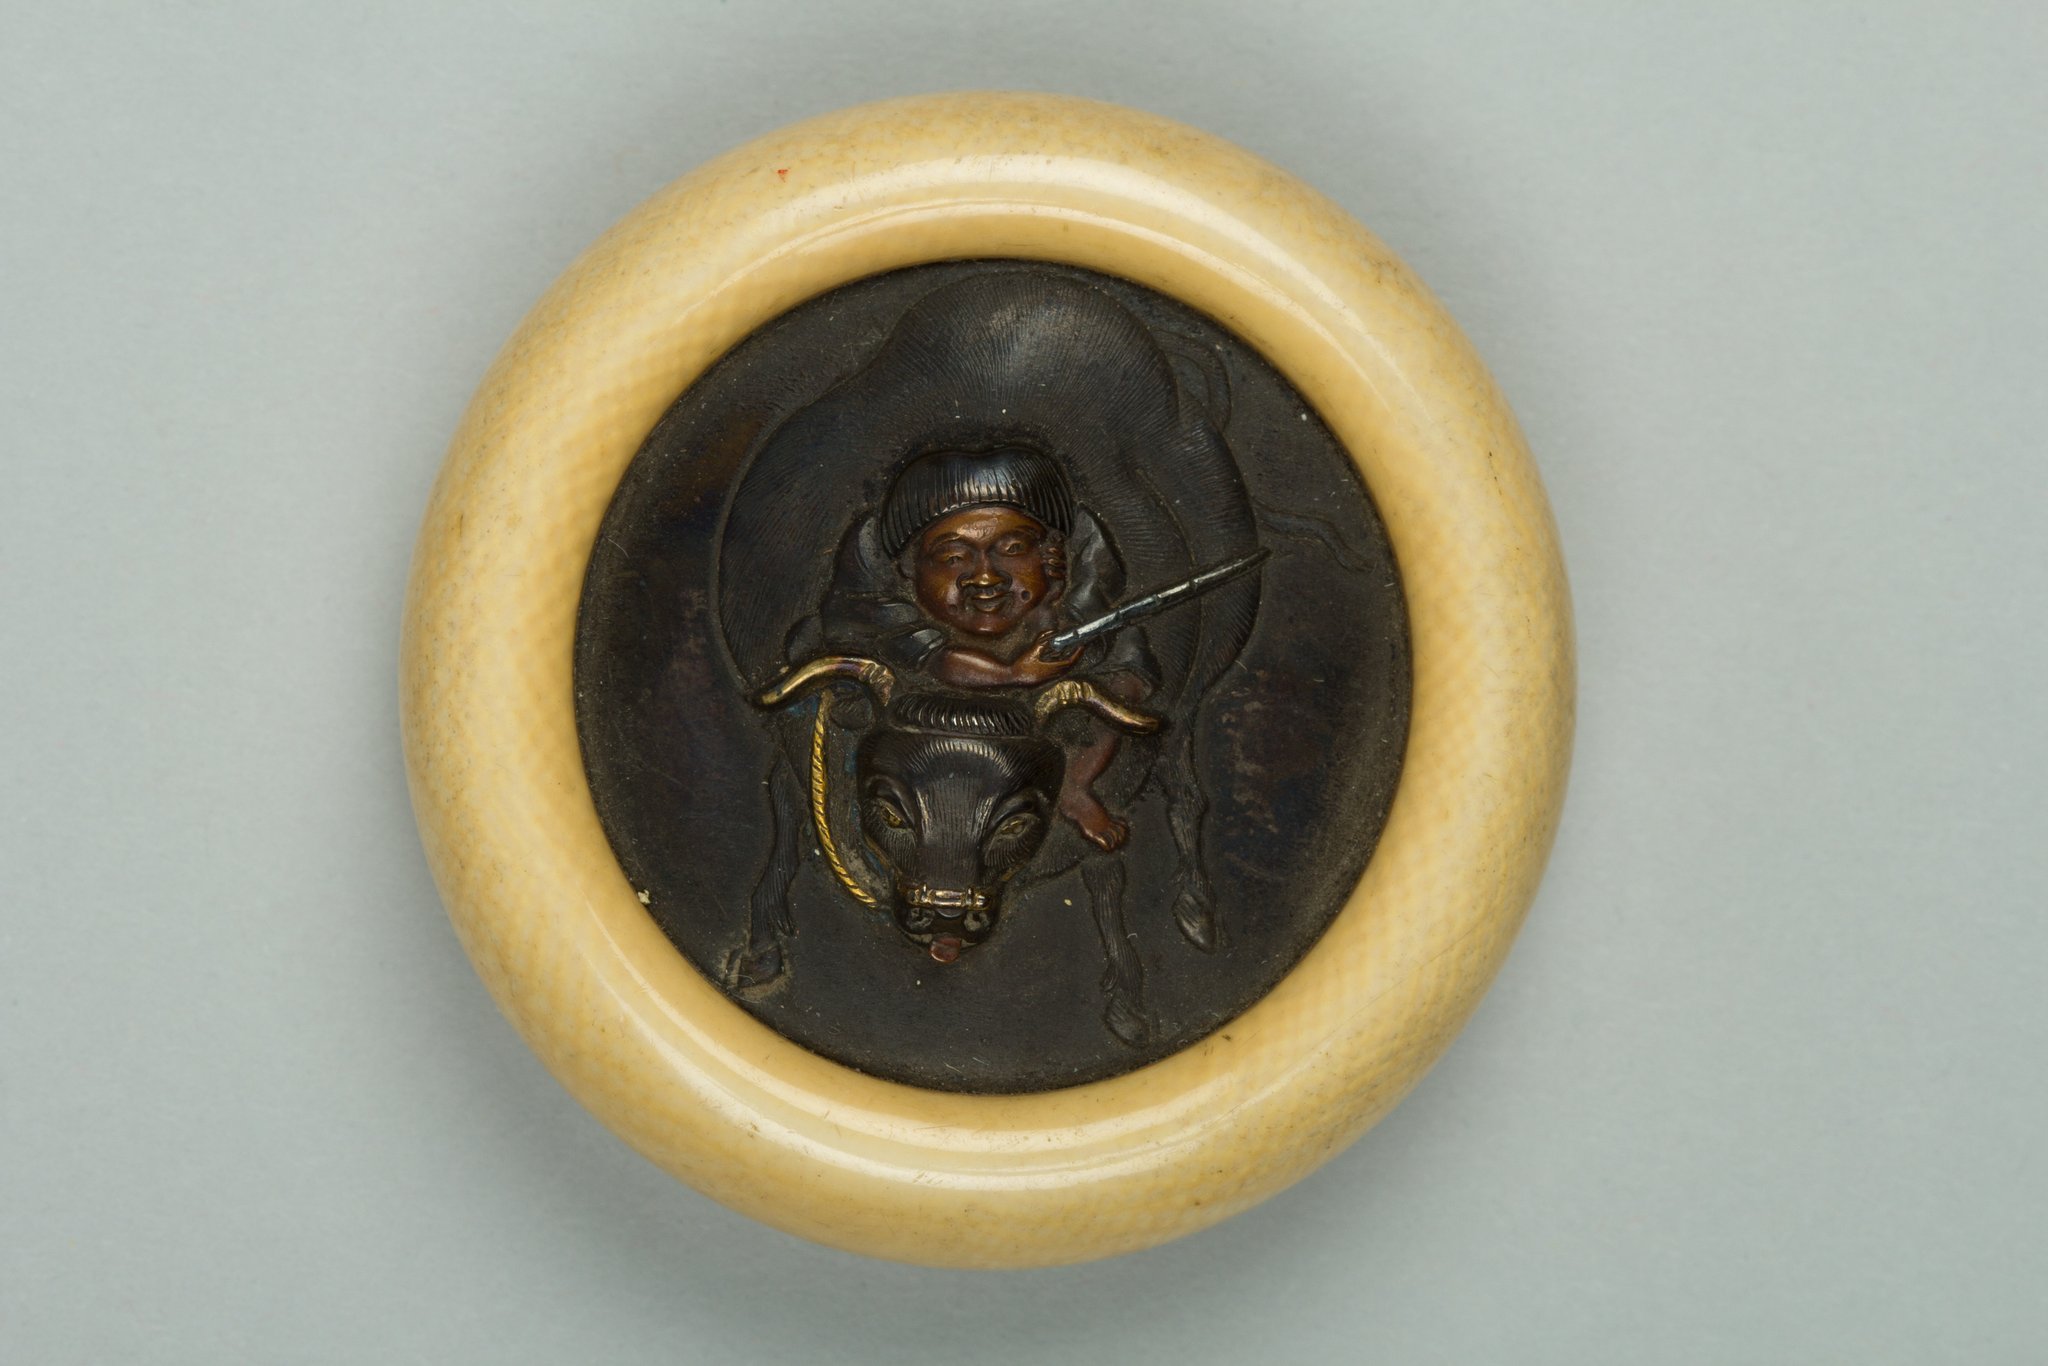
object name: netsuke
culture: japanese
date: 1801-1900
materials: gold, ivory, silver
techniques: inlay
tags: men